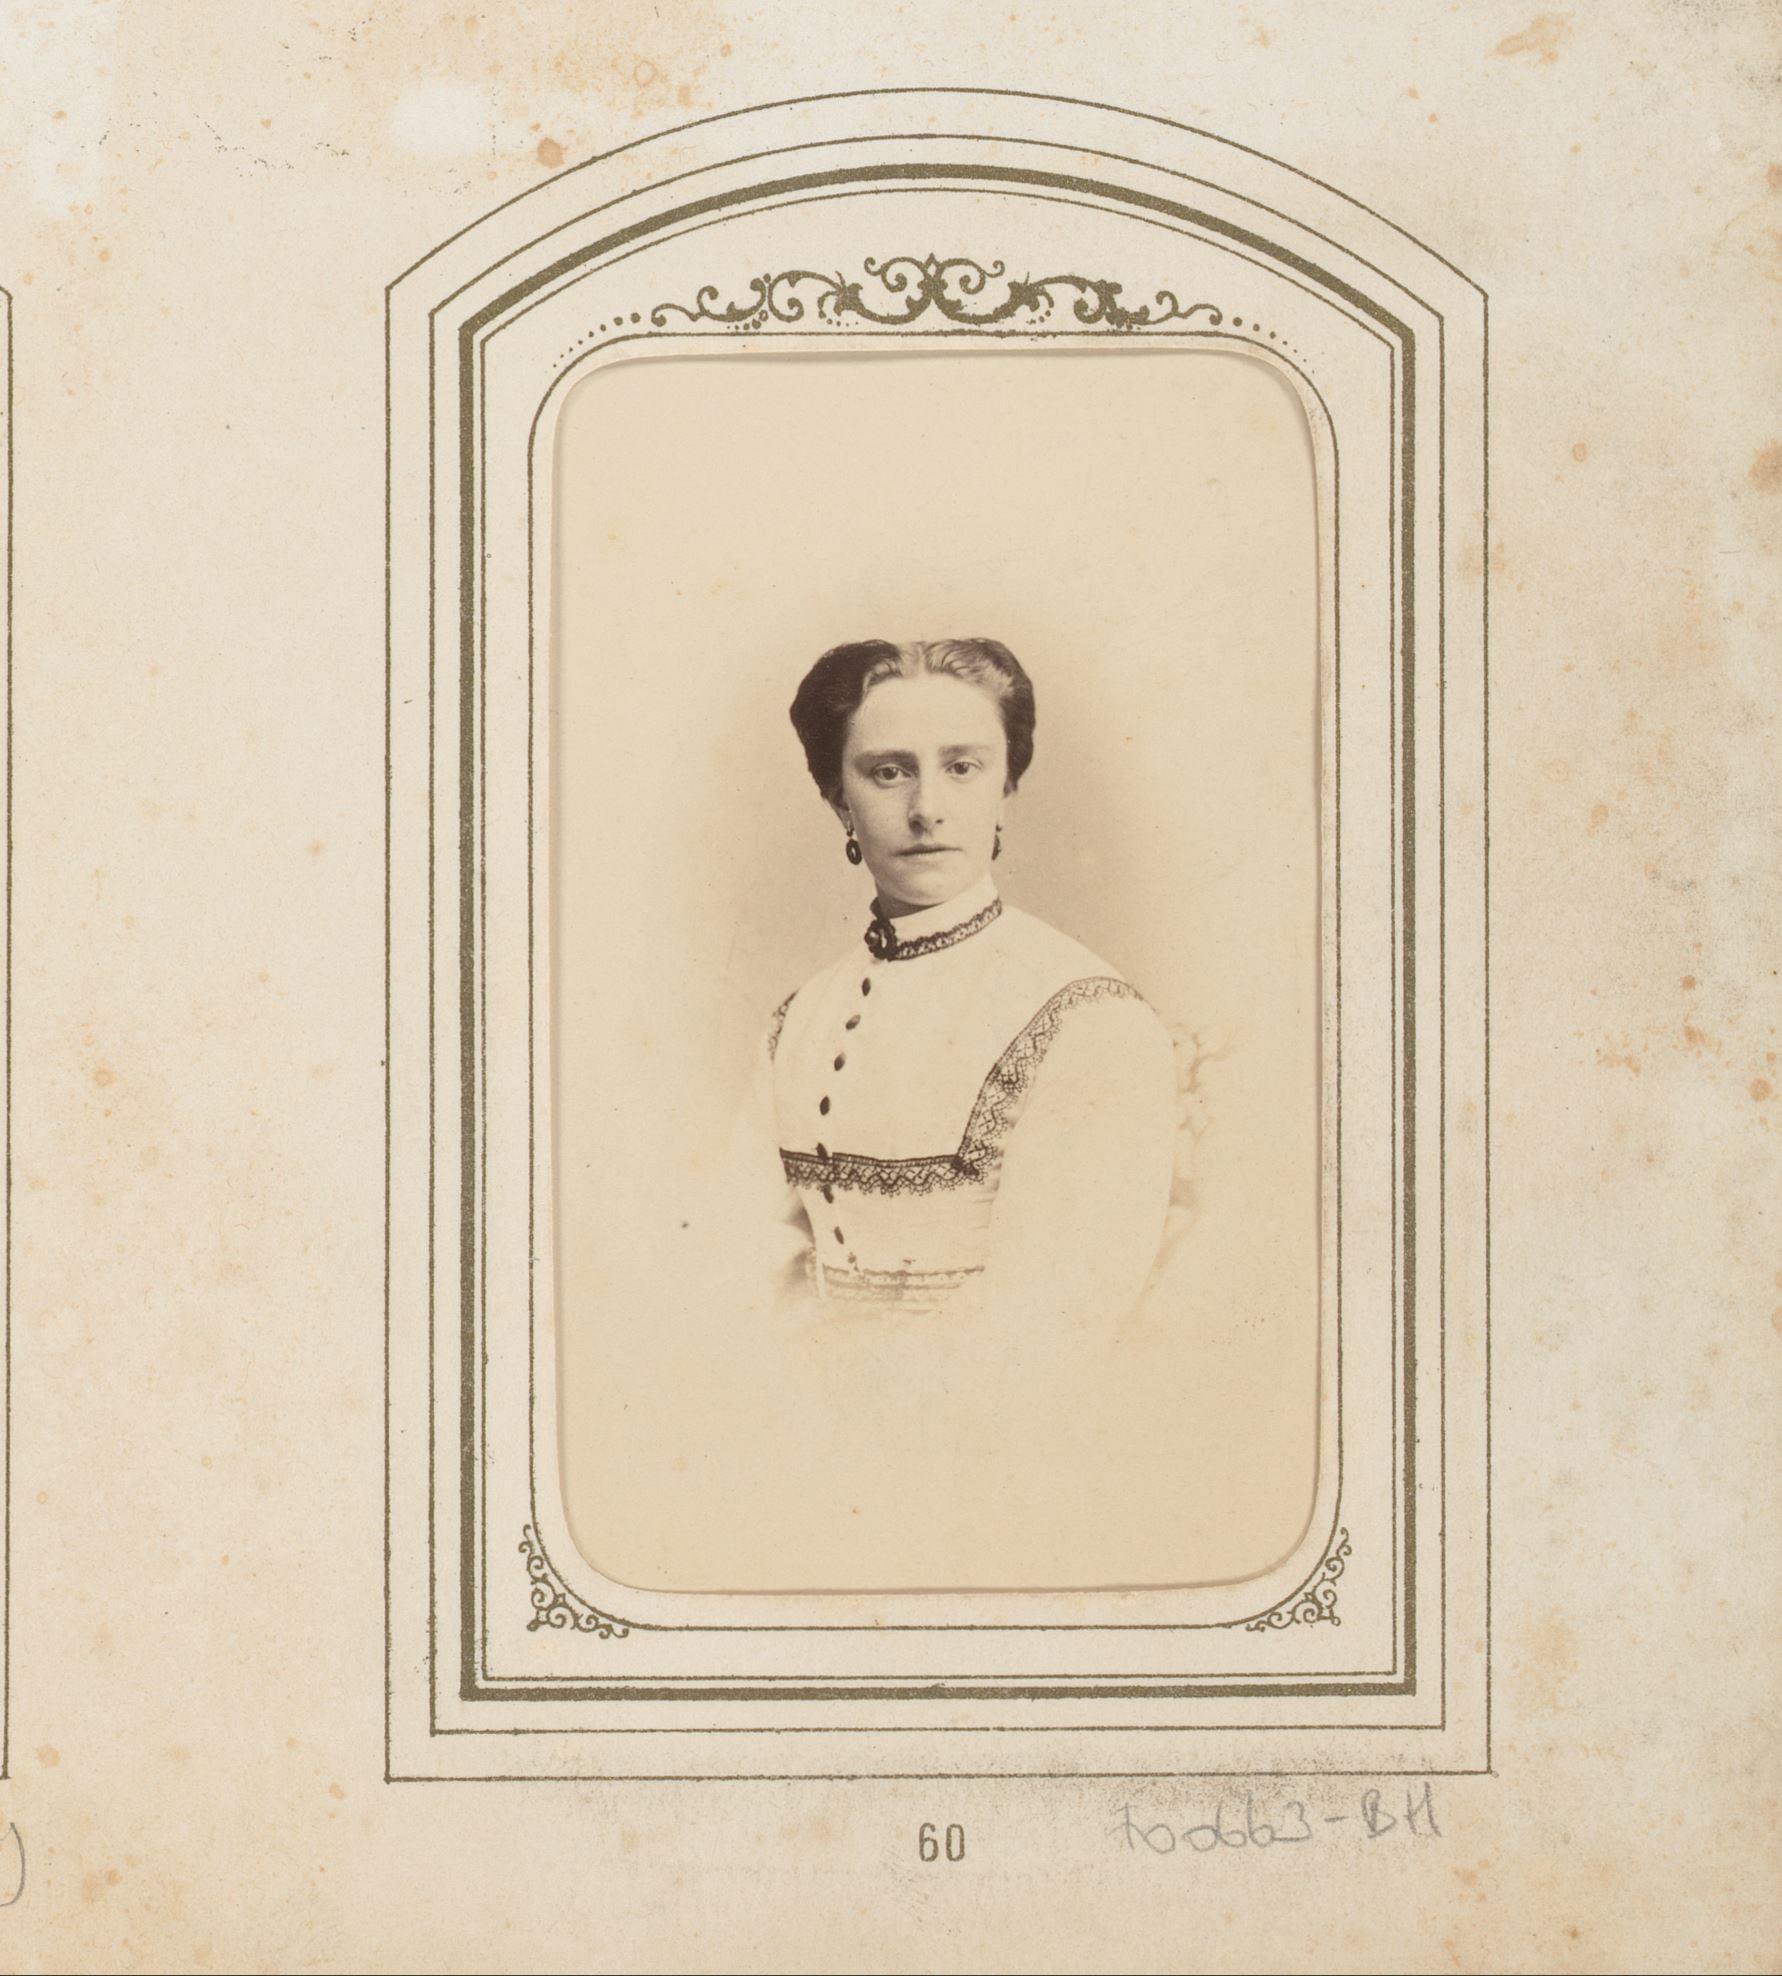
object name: carte de visite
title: Portret van een vrouw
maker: theodorus diepenbach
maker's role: fotograaf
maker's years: 1829-1940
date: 1860-1870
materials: cardboard, photographic support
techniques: albumen print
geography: cleves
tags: historical persons - bb - woman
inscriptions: inscription: ‘Th. Diepenbach/ Photograph/ 554 Kurze Marktstrasse 554/ Cleve’, number: ‘60’